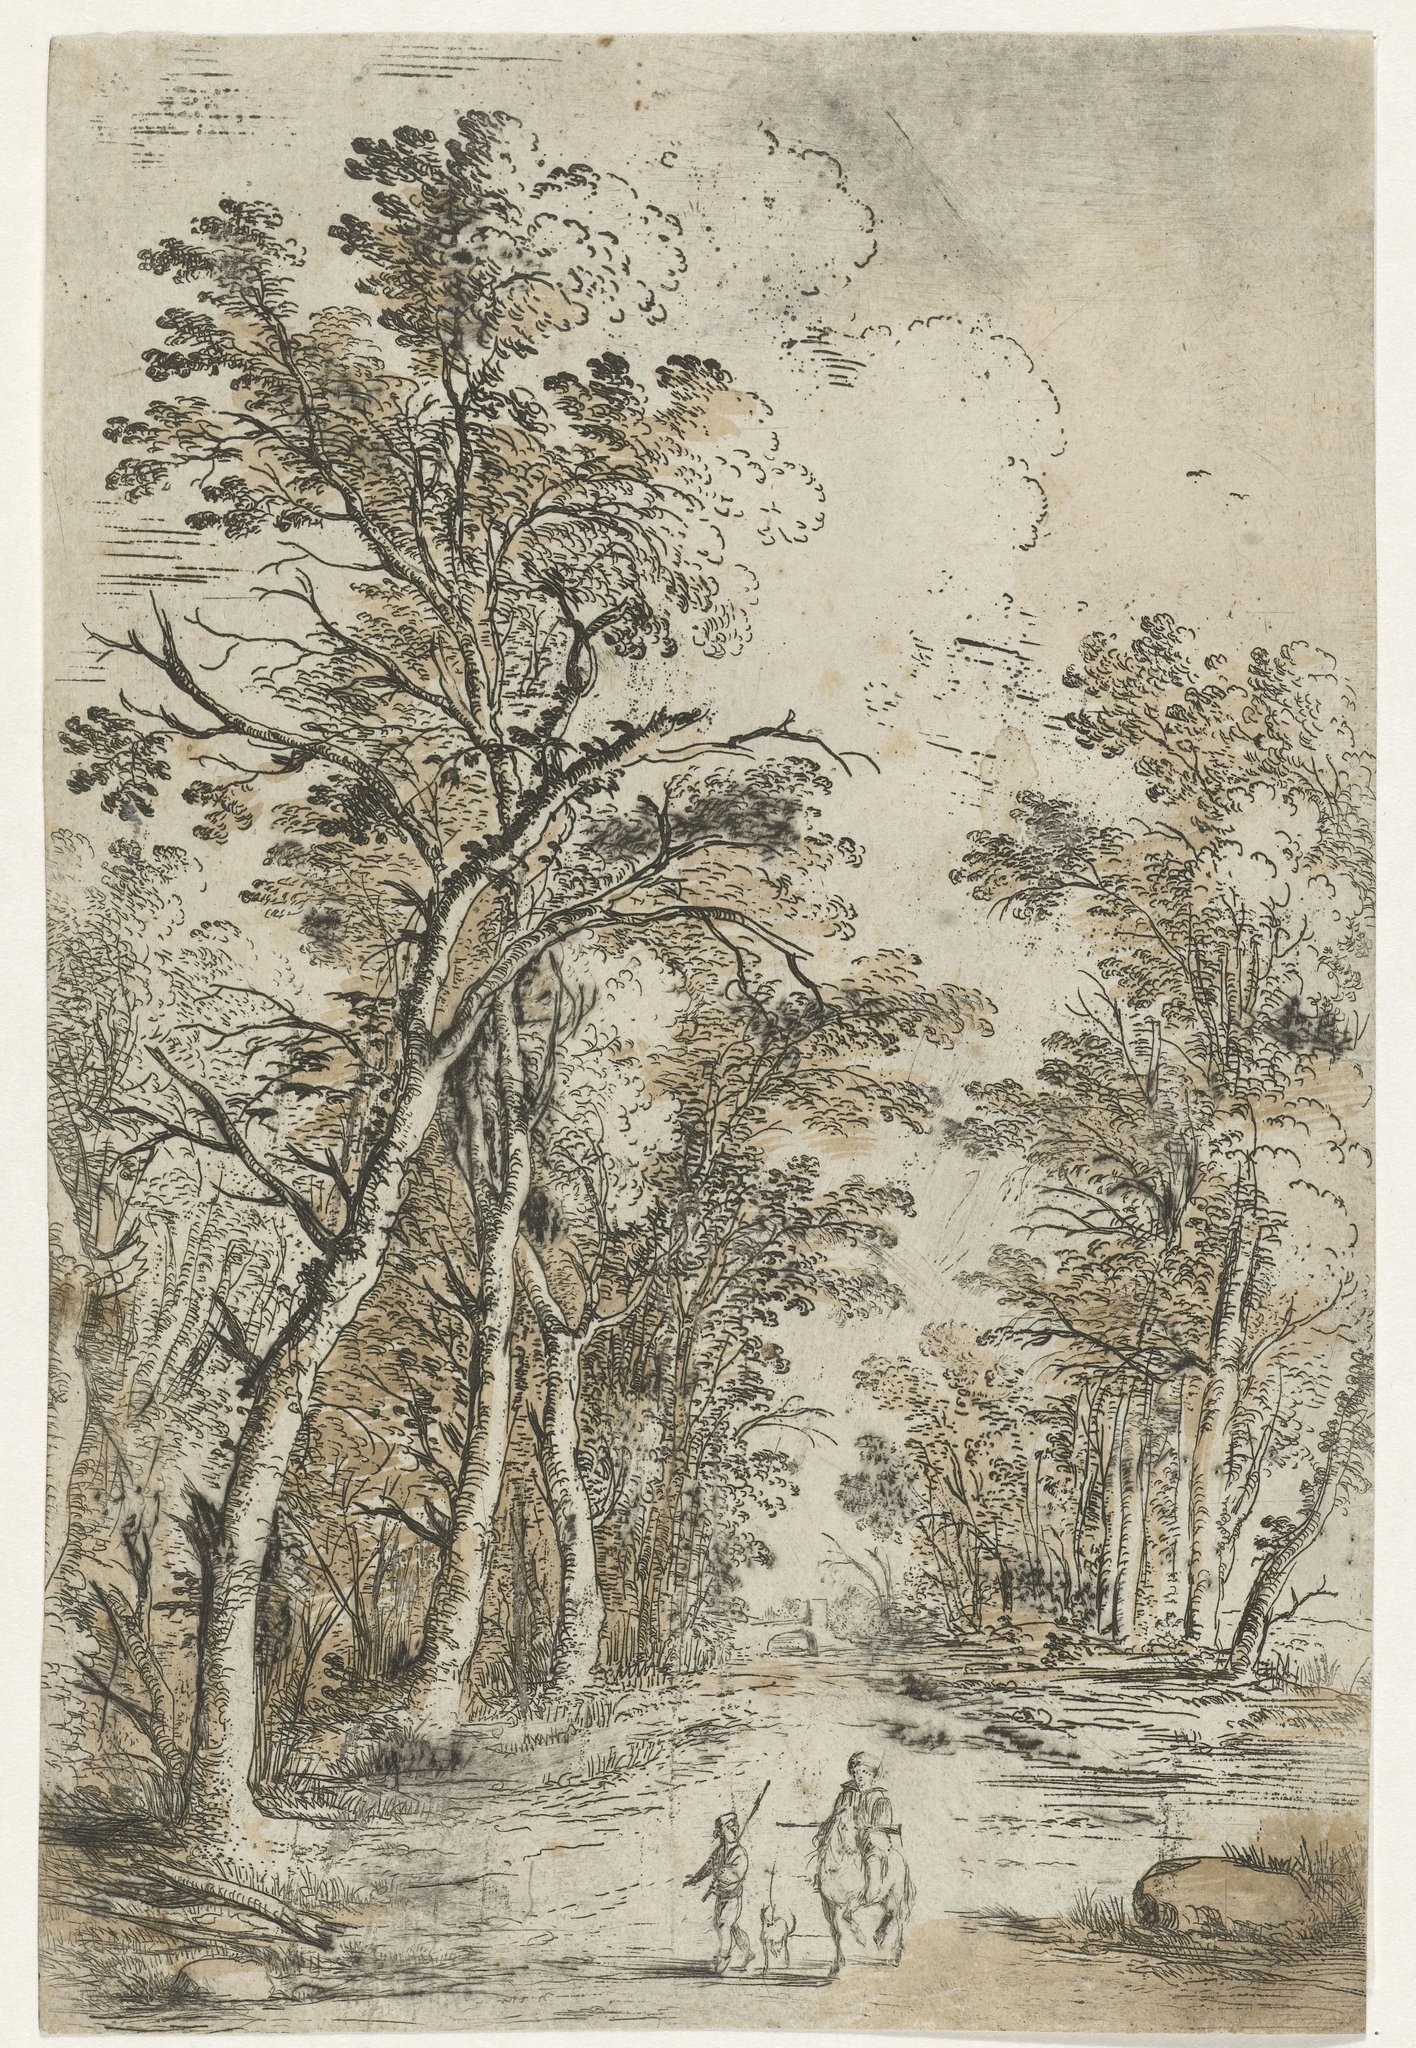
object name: print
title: Bospad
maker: jan fouceel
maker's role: print maker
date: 1665-1675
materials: chalk, ink, paper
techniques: brush, etching, pen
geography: antwerp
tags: riding a horse, ass, or mule; rider, horseman, forest path or lane, dog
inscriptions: collector's mark: Lugt 2228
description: Bospad met een ruiter, een wandelaar en een hond. Op het verso een studie van een engel.